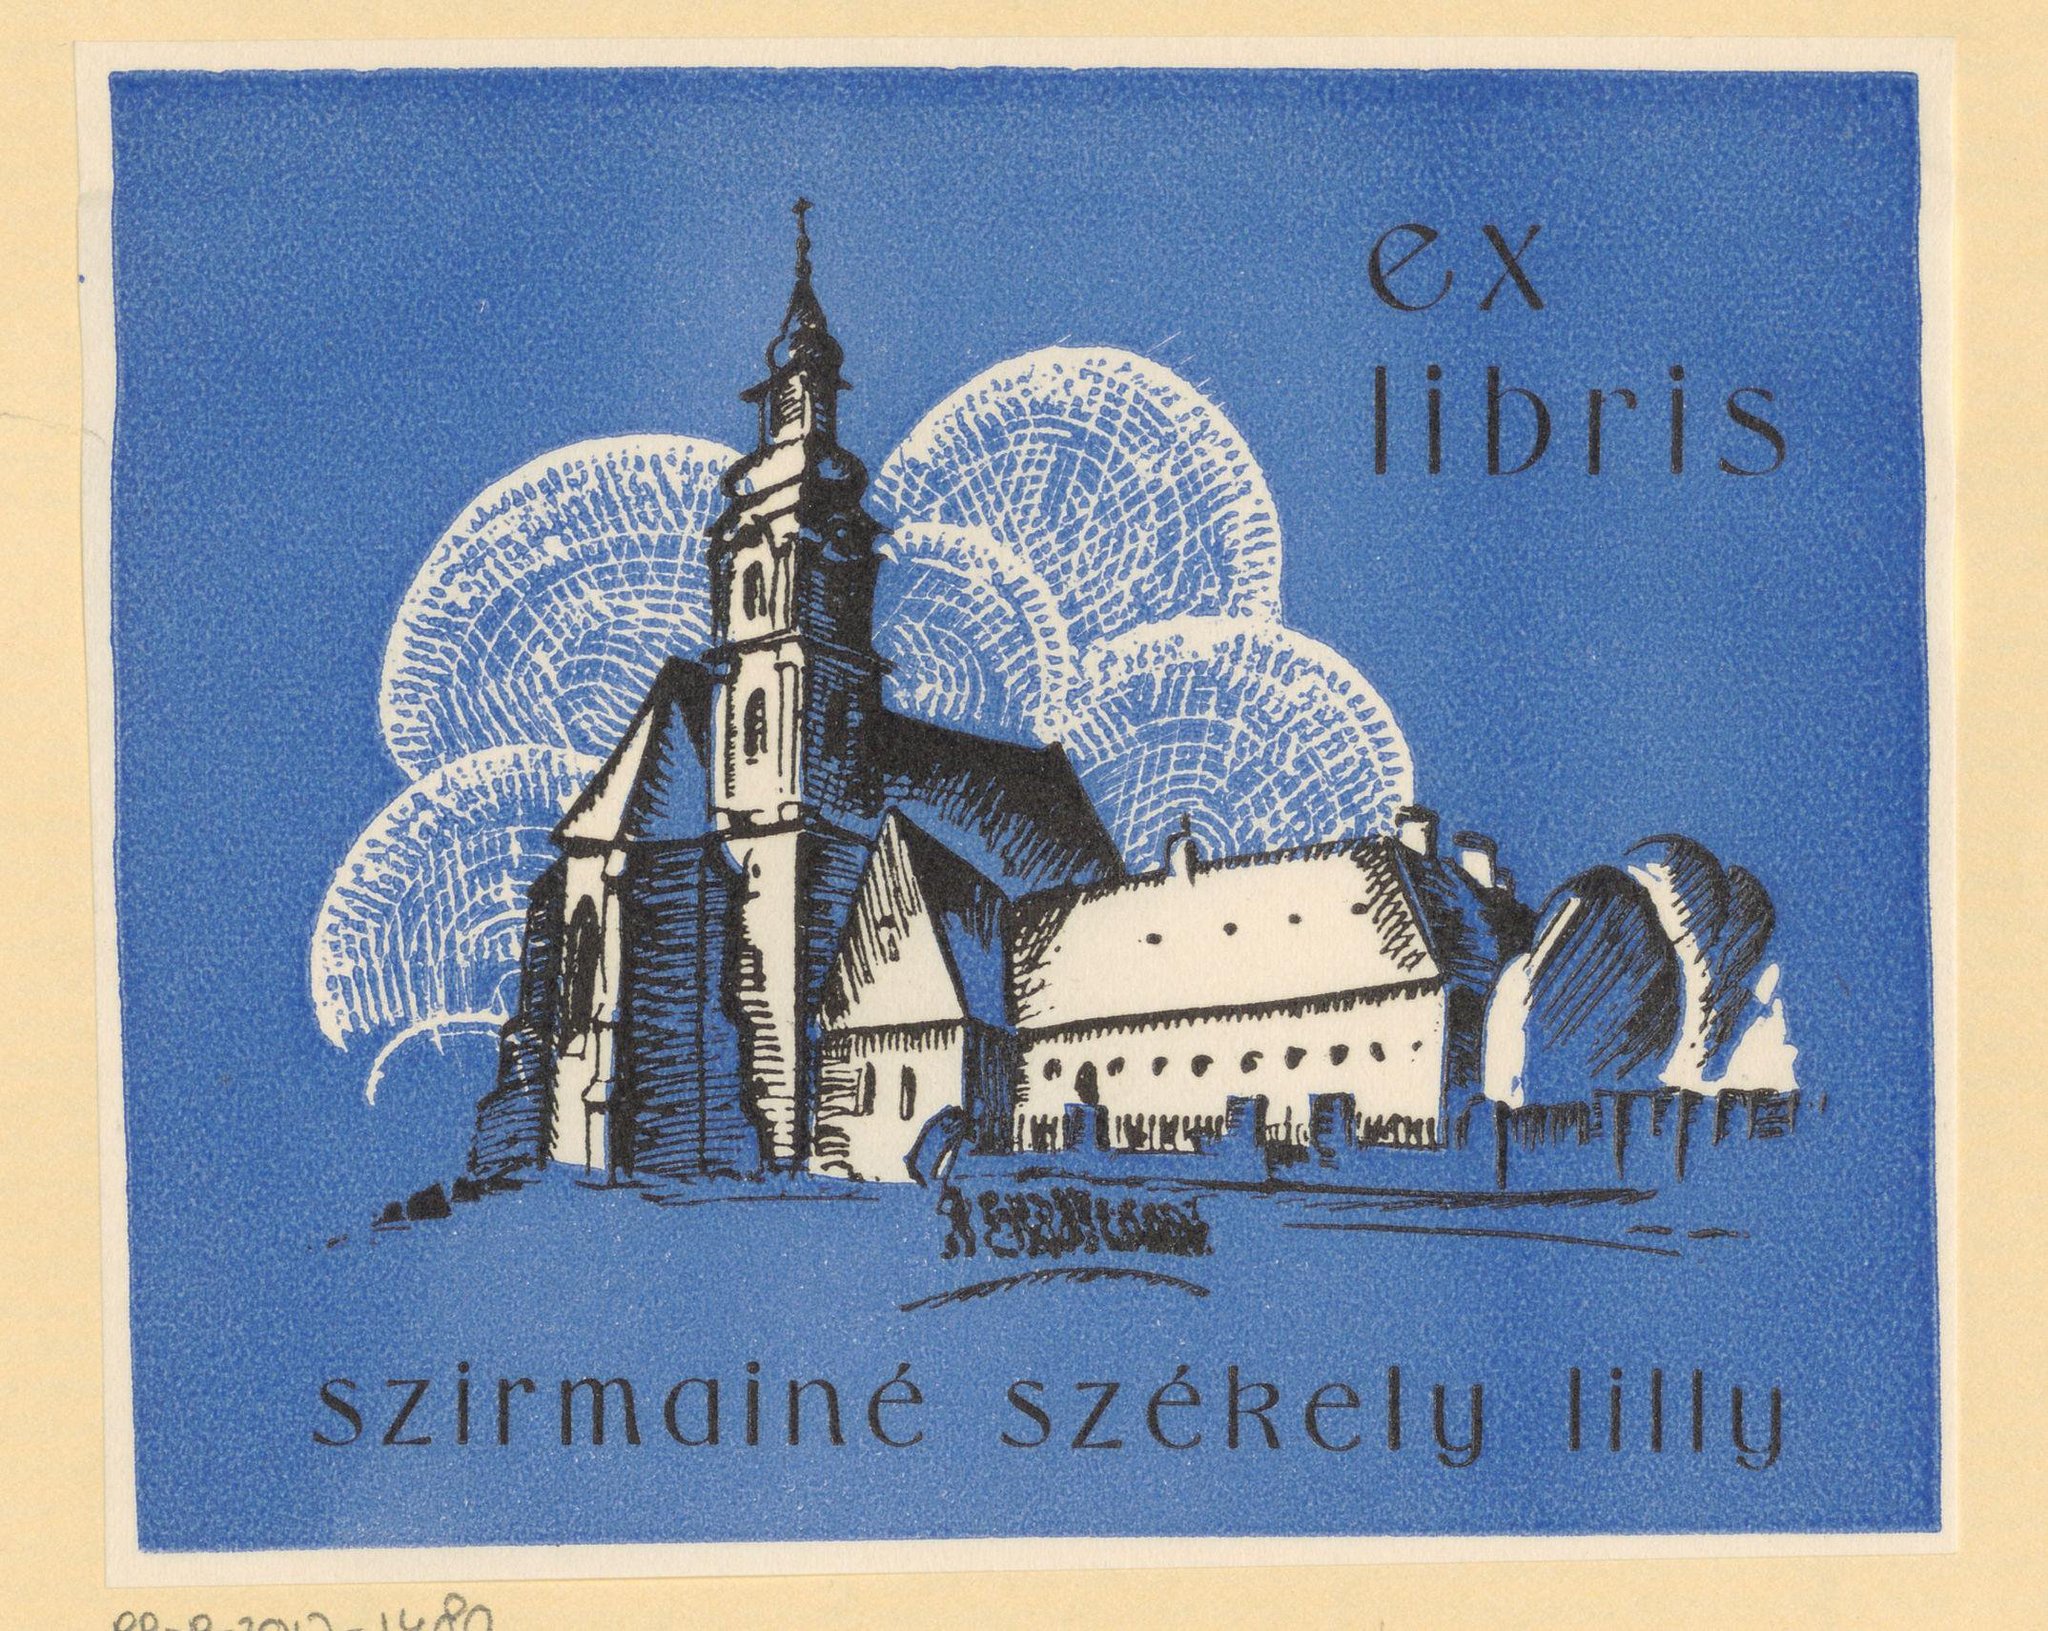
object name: bookplate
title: Ex libris van Lilly Szirmainé Székely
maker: lászló bartos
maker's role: print maker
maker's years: 1902-1943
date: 1912-1943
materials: paper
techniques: linocut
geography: hungary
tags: adult woman, reading